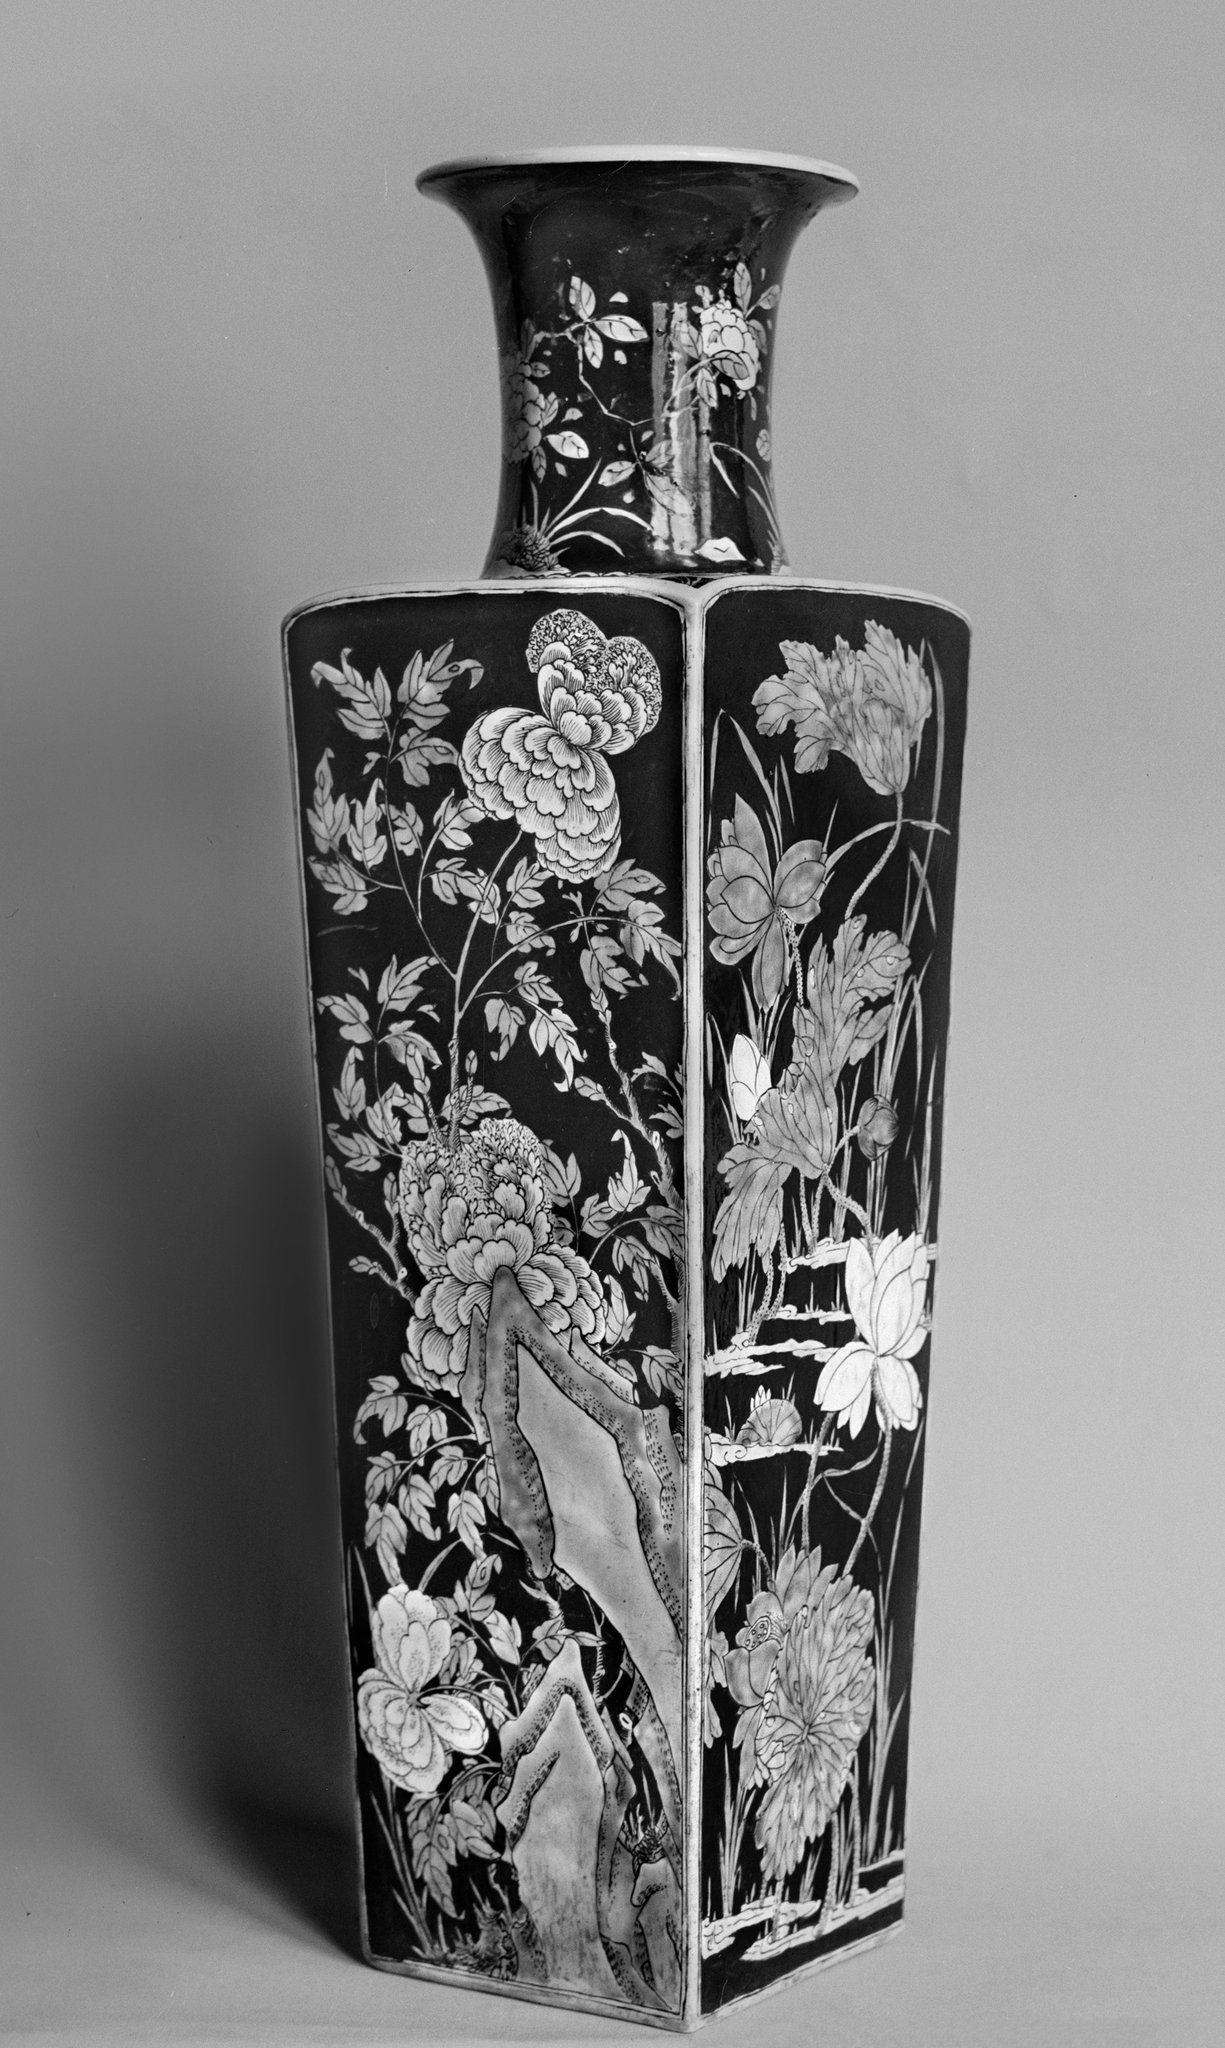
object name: vase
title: Square vase with flowers of four seasons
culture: chinese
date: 1801-1900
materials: enamel, porcelain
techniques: painting, polychrome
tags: flowers